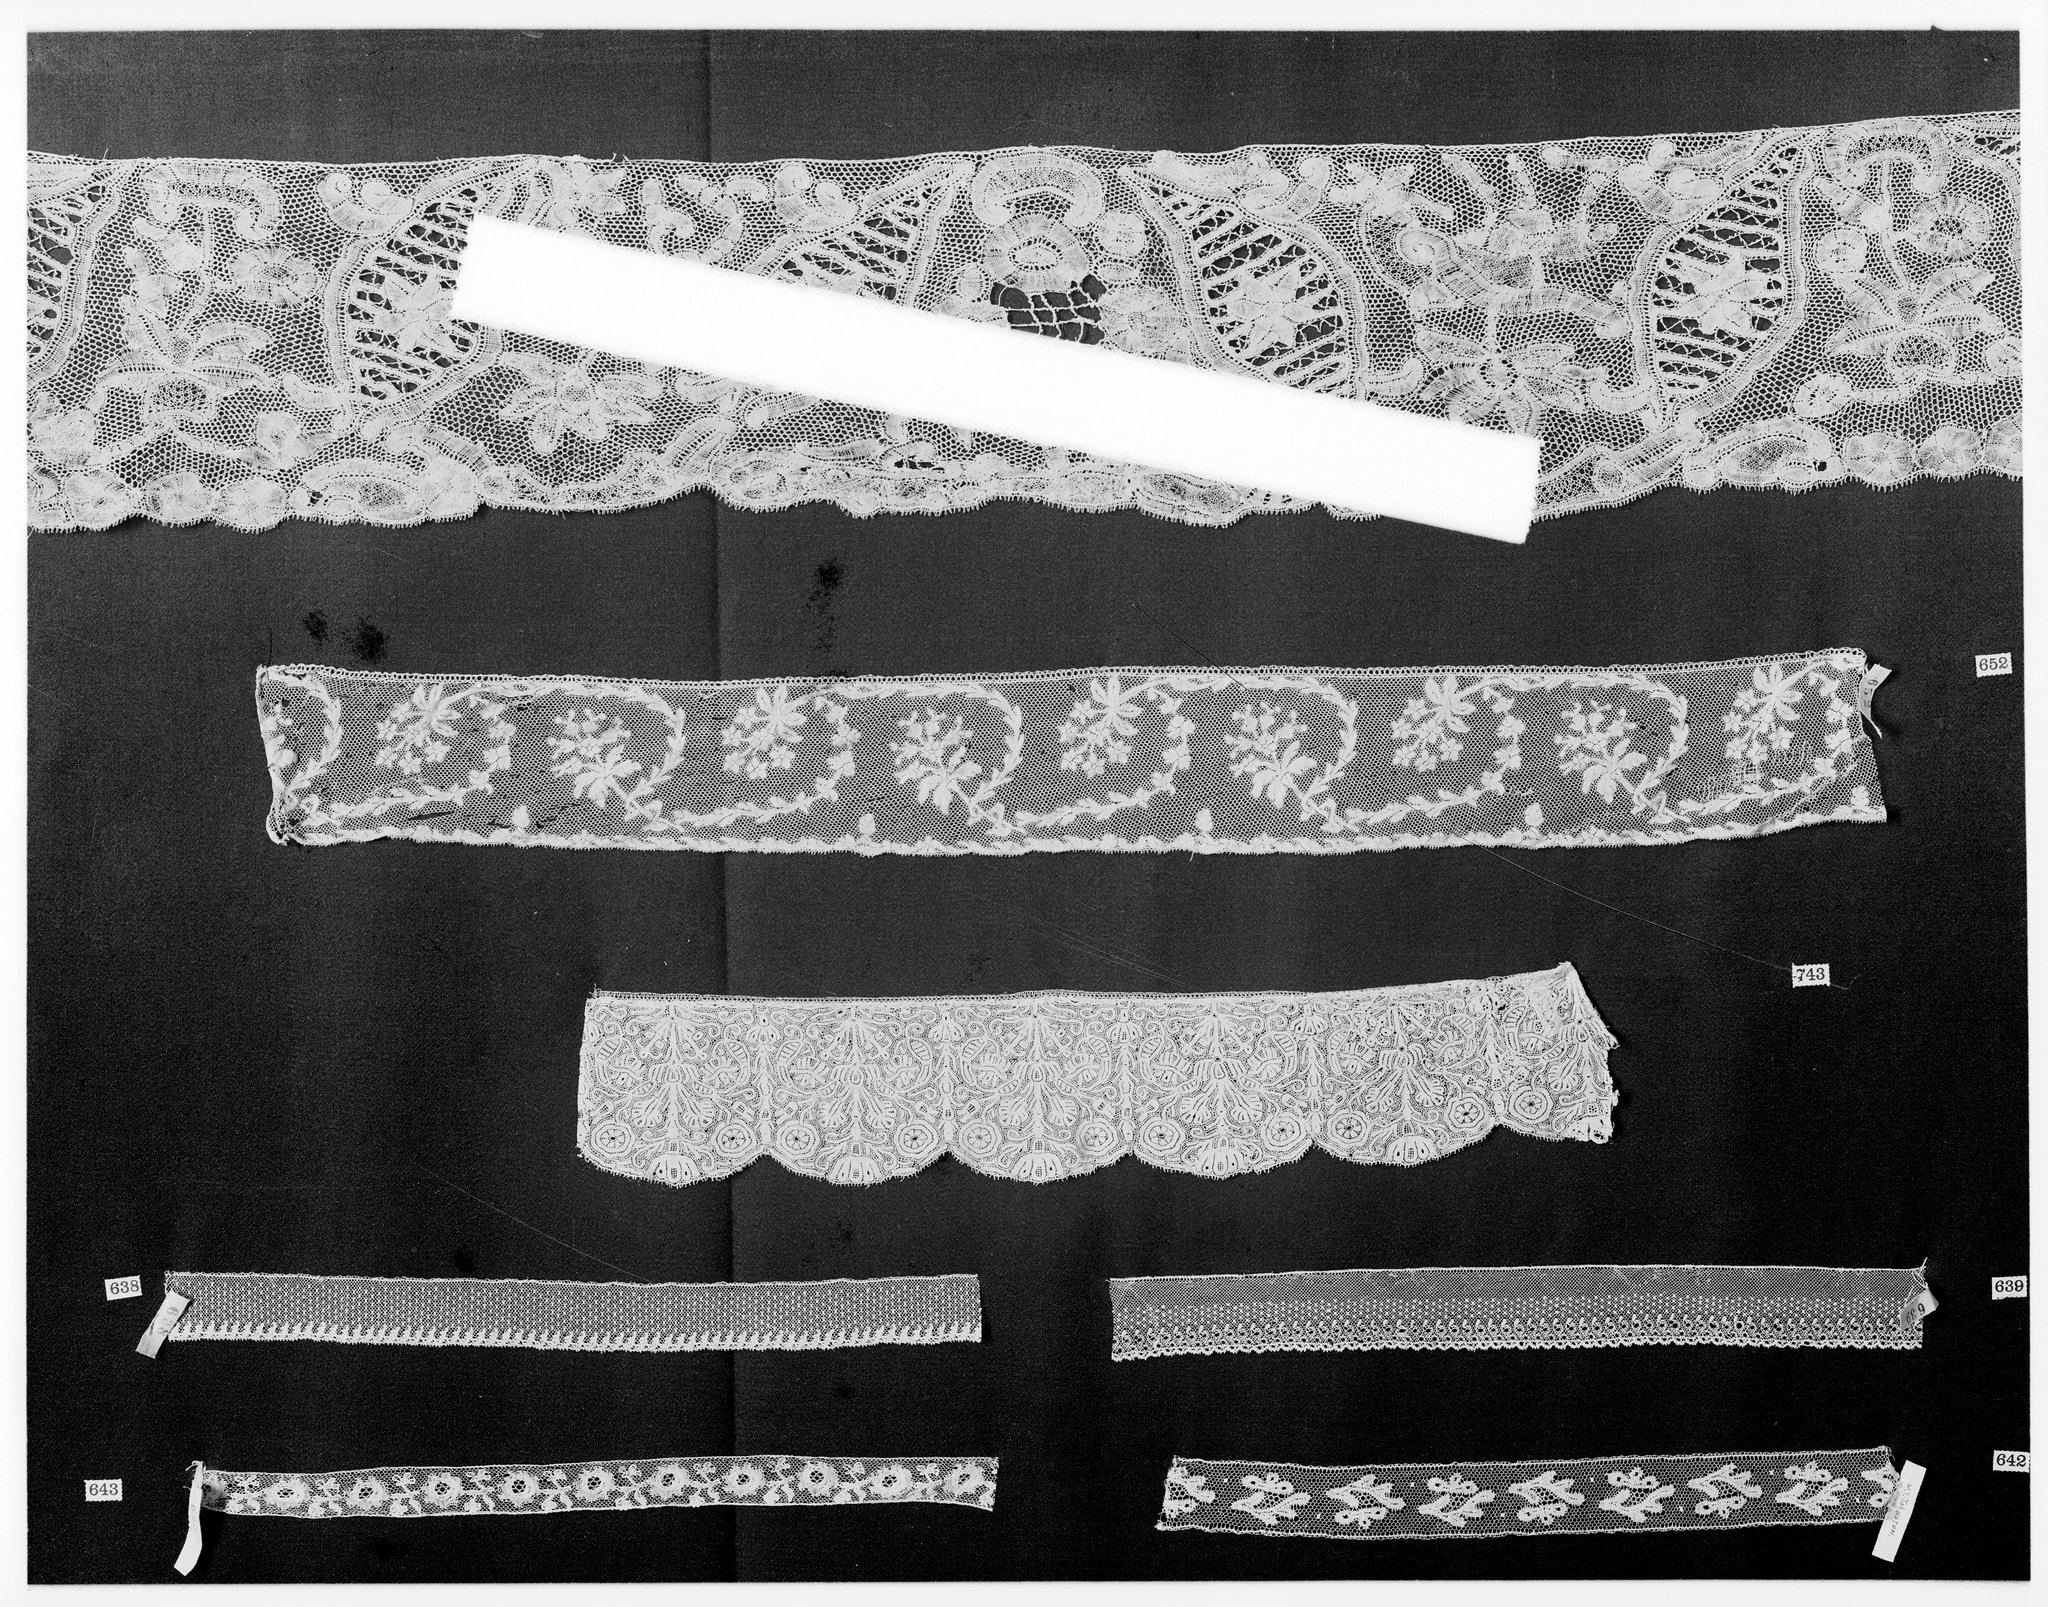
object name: fragment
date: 1701-1733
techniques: lace